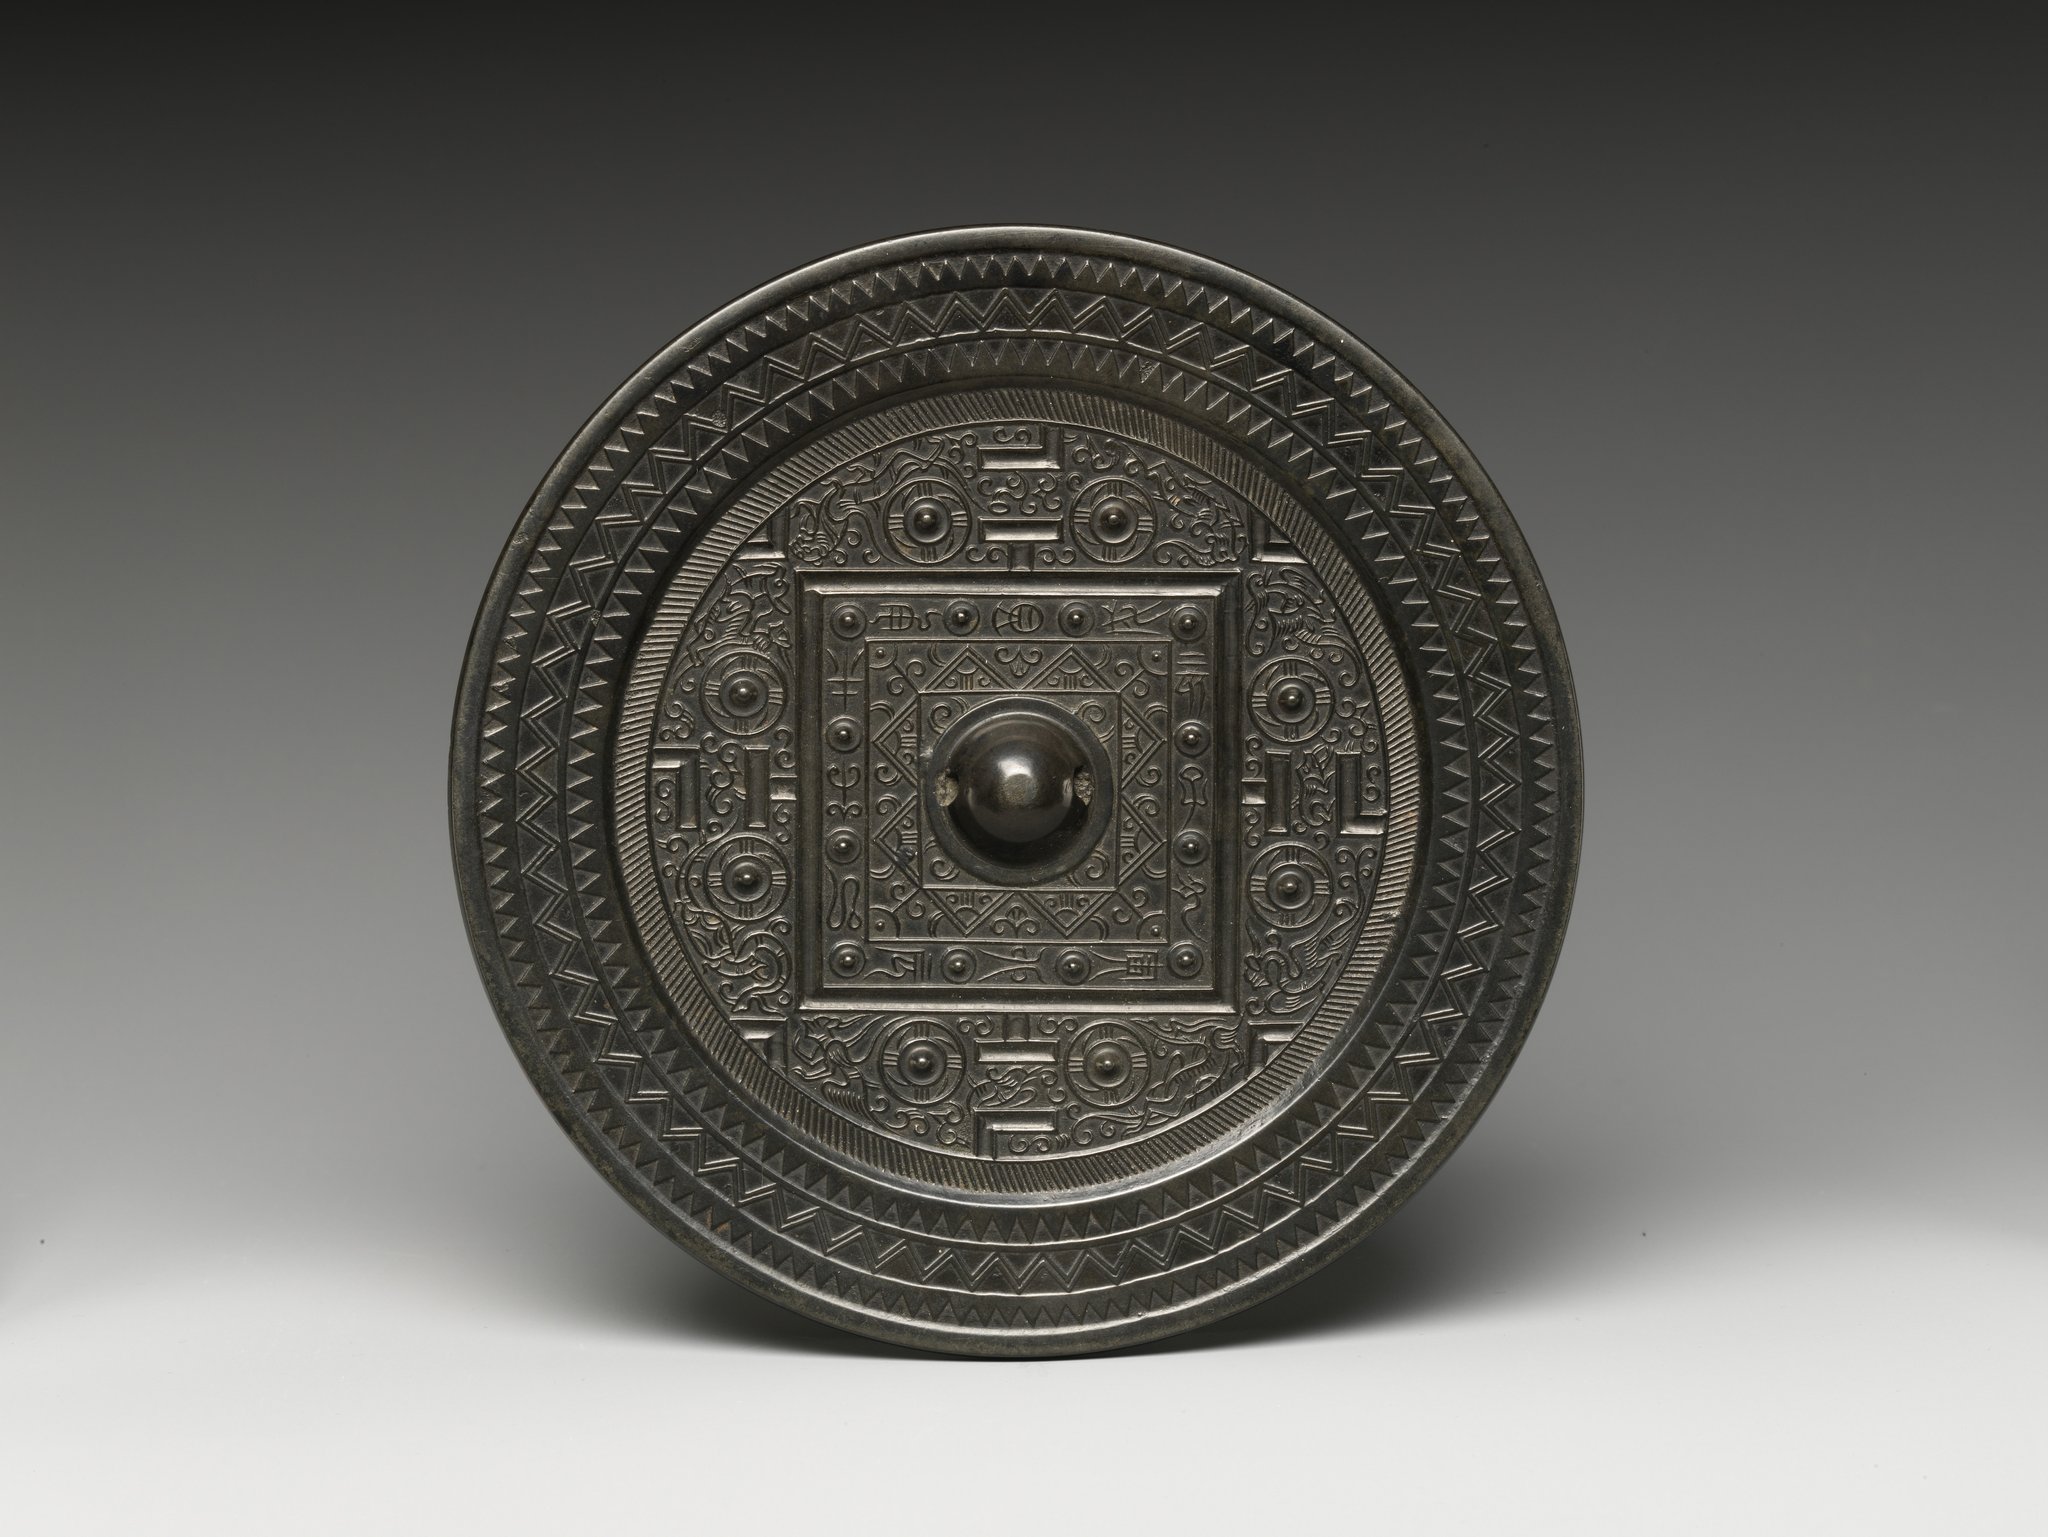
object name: mirror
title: Mirror with game board design and animals of the four directions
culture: chinese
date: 1-200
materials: bronze, patina